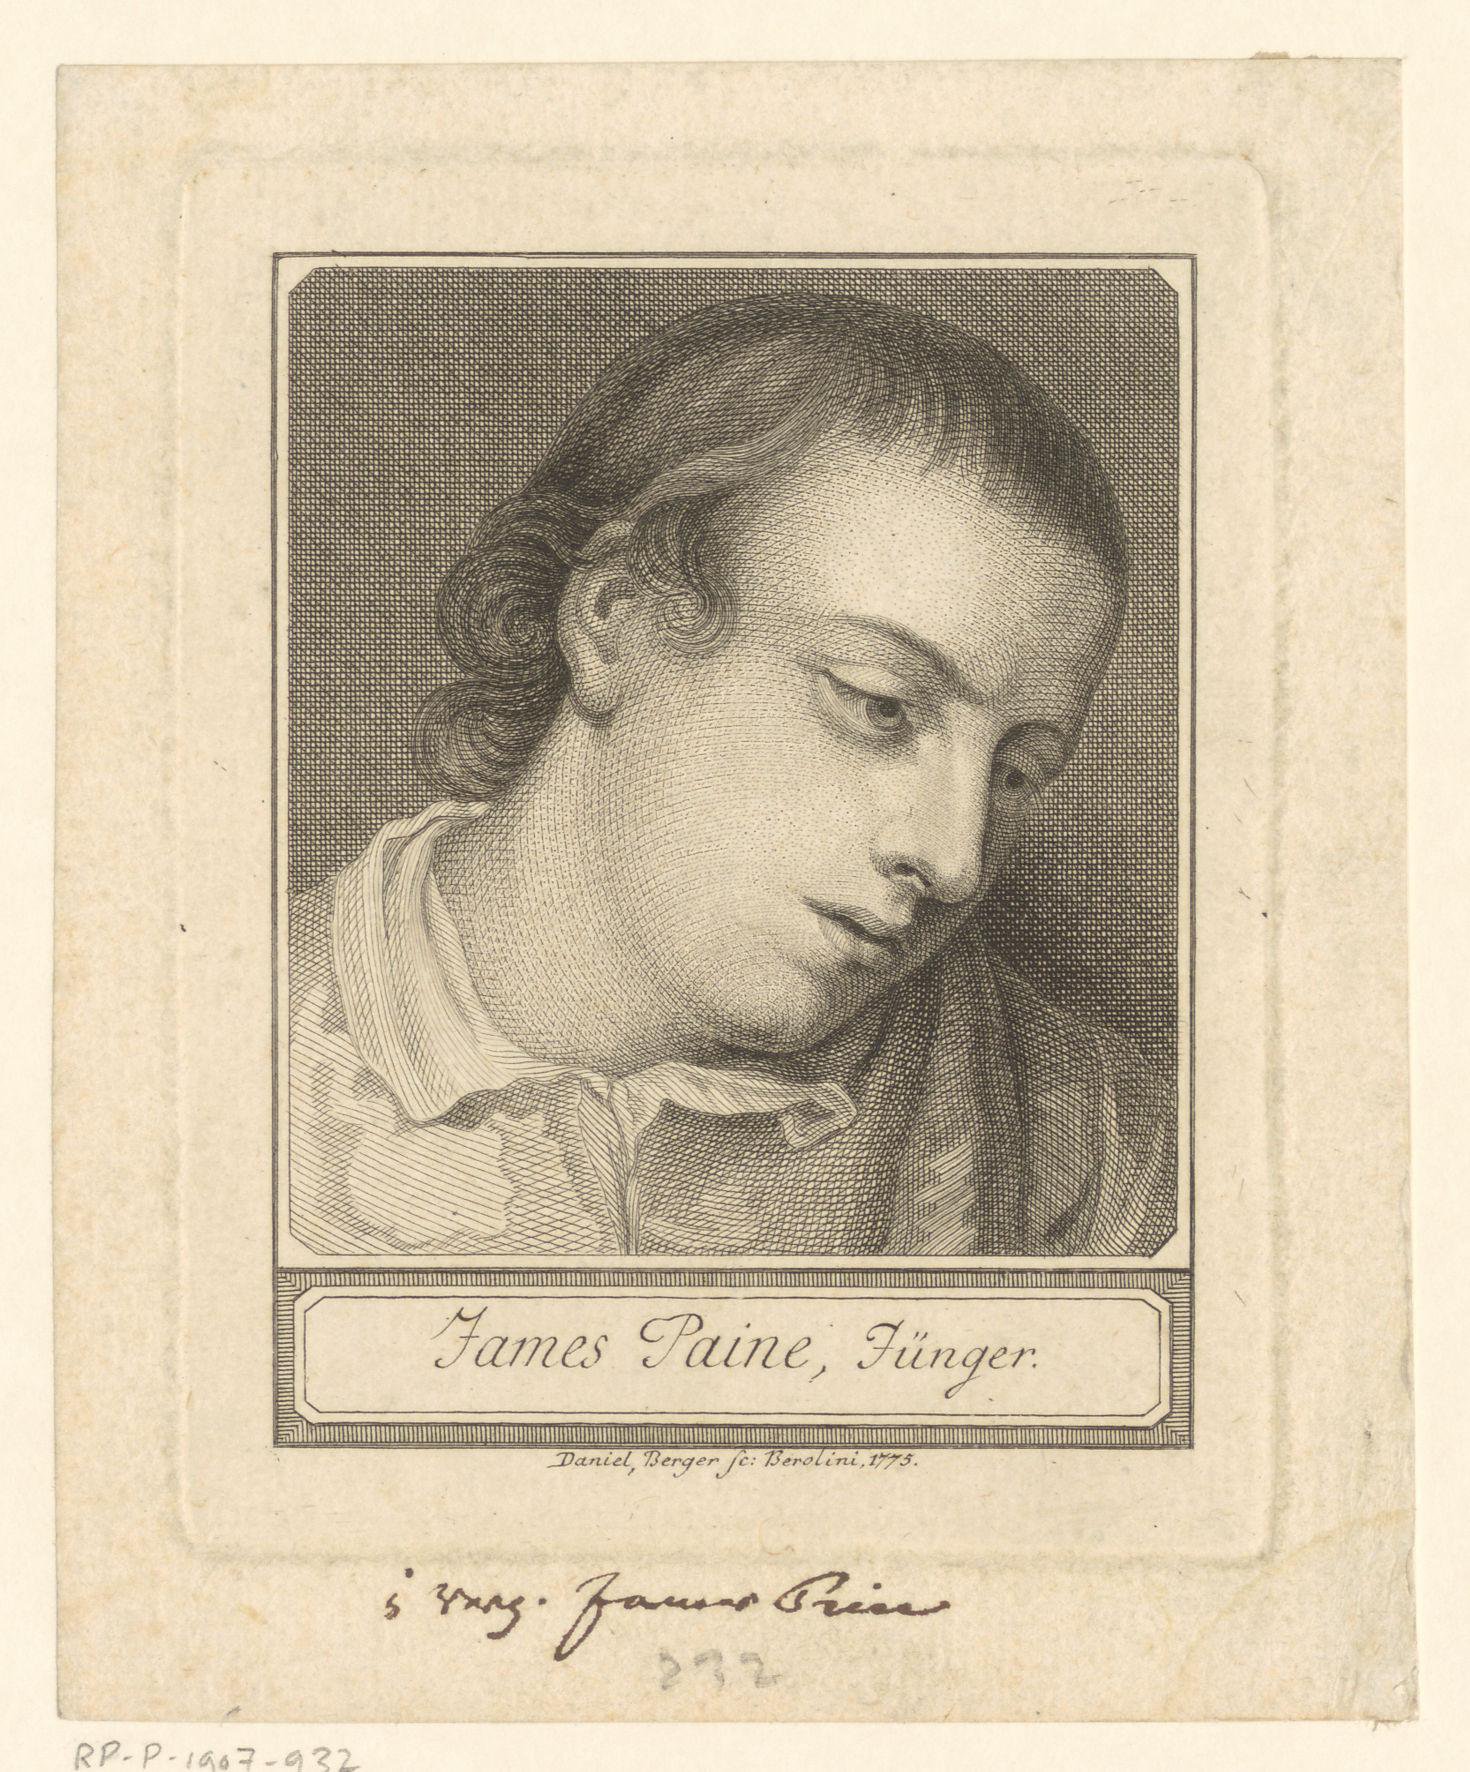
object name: print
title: Portret van James Paine II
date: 1775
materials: paper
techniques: etching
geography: berlin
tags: historical persons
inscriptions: collector's mark: Lugt 2228